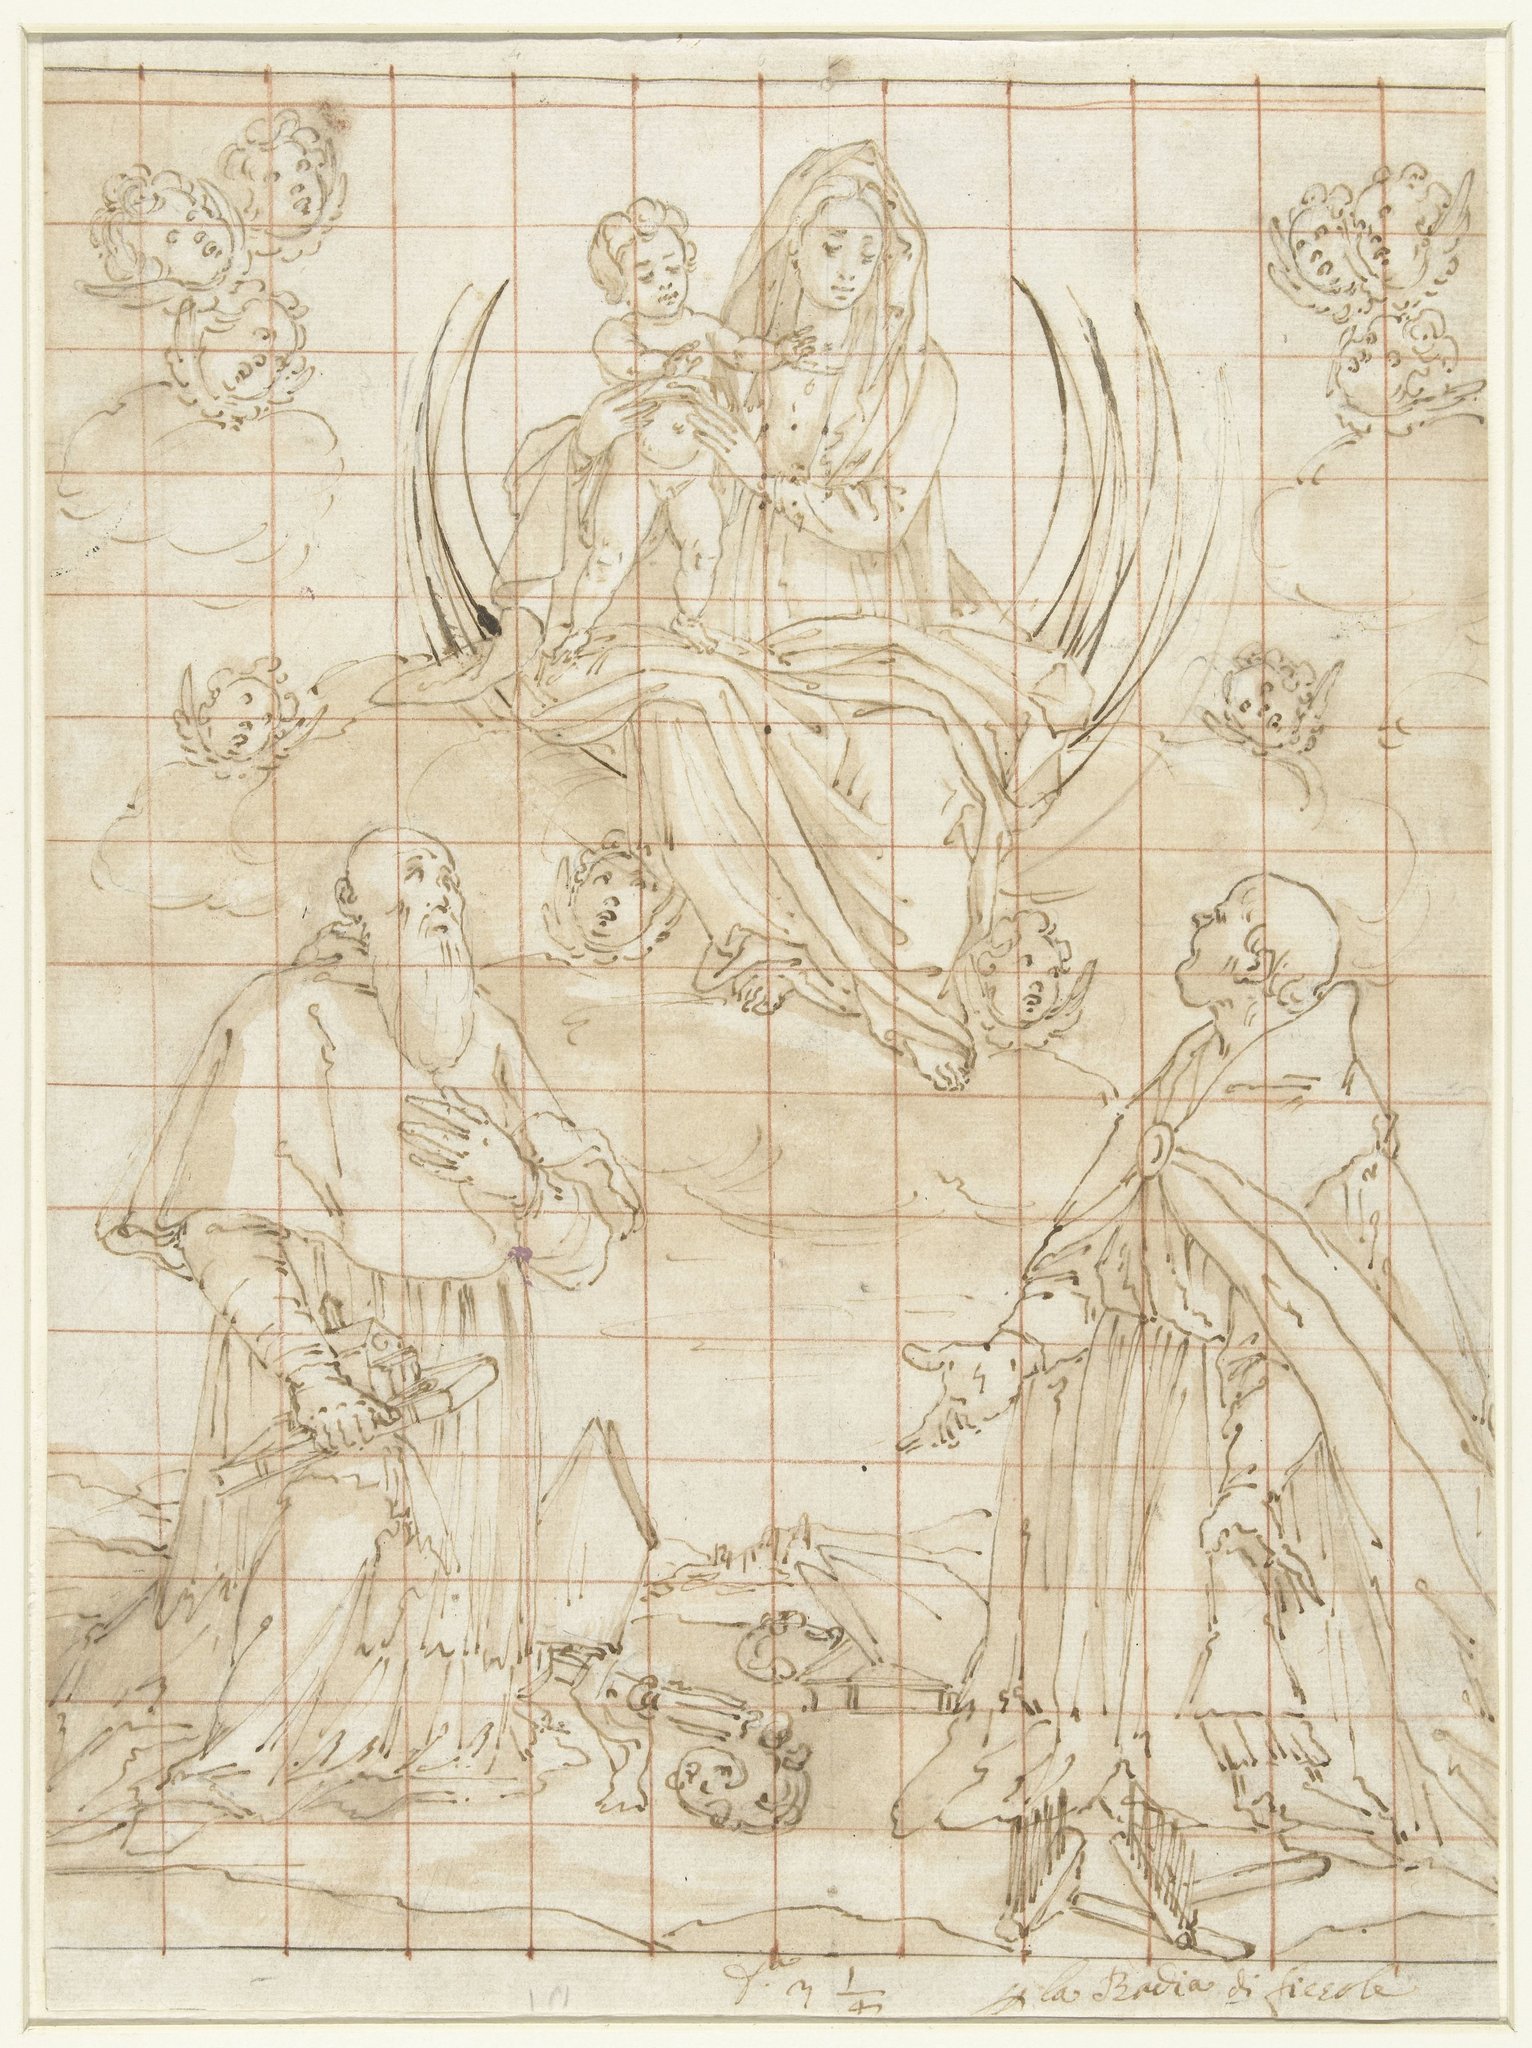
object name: drawing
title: Madonna vereerd door twee heiligen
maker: jacopo da empoli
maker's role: draughtsman, painter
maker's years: 1554-1640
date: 1575-1700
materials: chalk, graphite, ink, paper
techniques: brush, pen, drawing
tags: benedict of nurcia, abbot of monte cassino and founder of the benedictine order; possible attributes: aspergillum, book, cup (sometimes broken), raven with loaf, sieve (or tray), madonna accompanied by saint(s)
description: Madonna tronend op een halve maan op wolken, vereerd door twee heiligen (mogelijk de H. Benedictus of de H. Fredianus), die voor haar knielen. Ontwerp voor een schilderij.